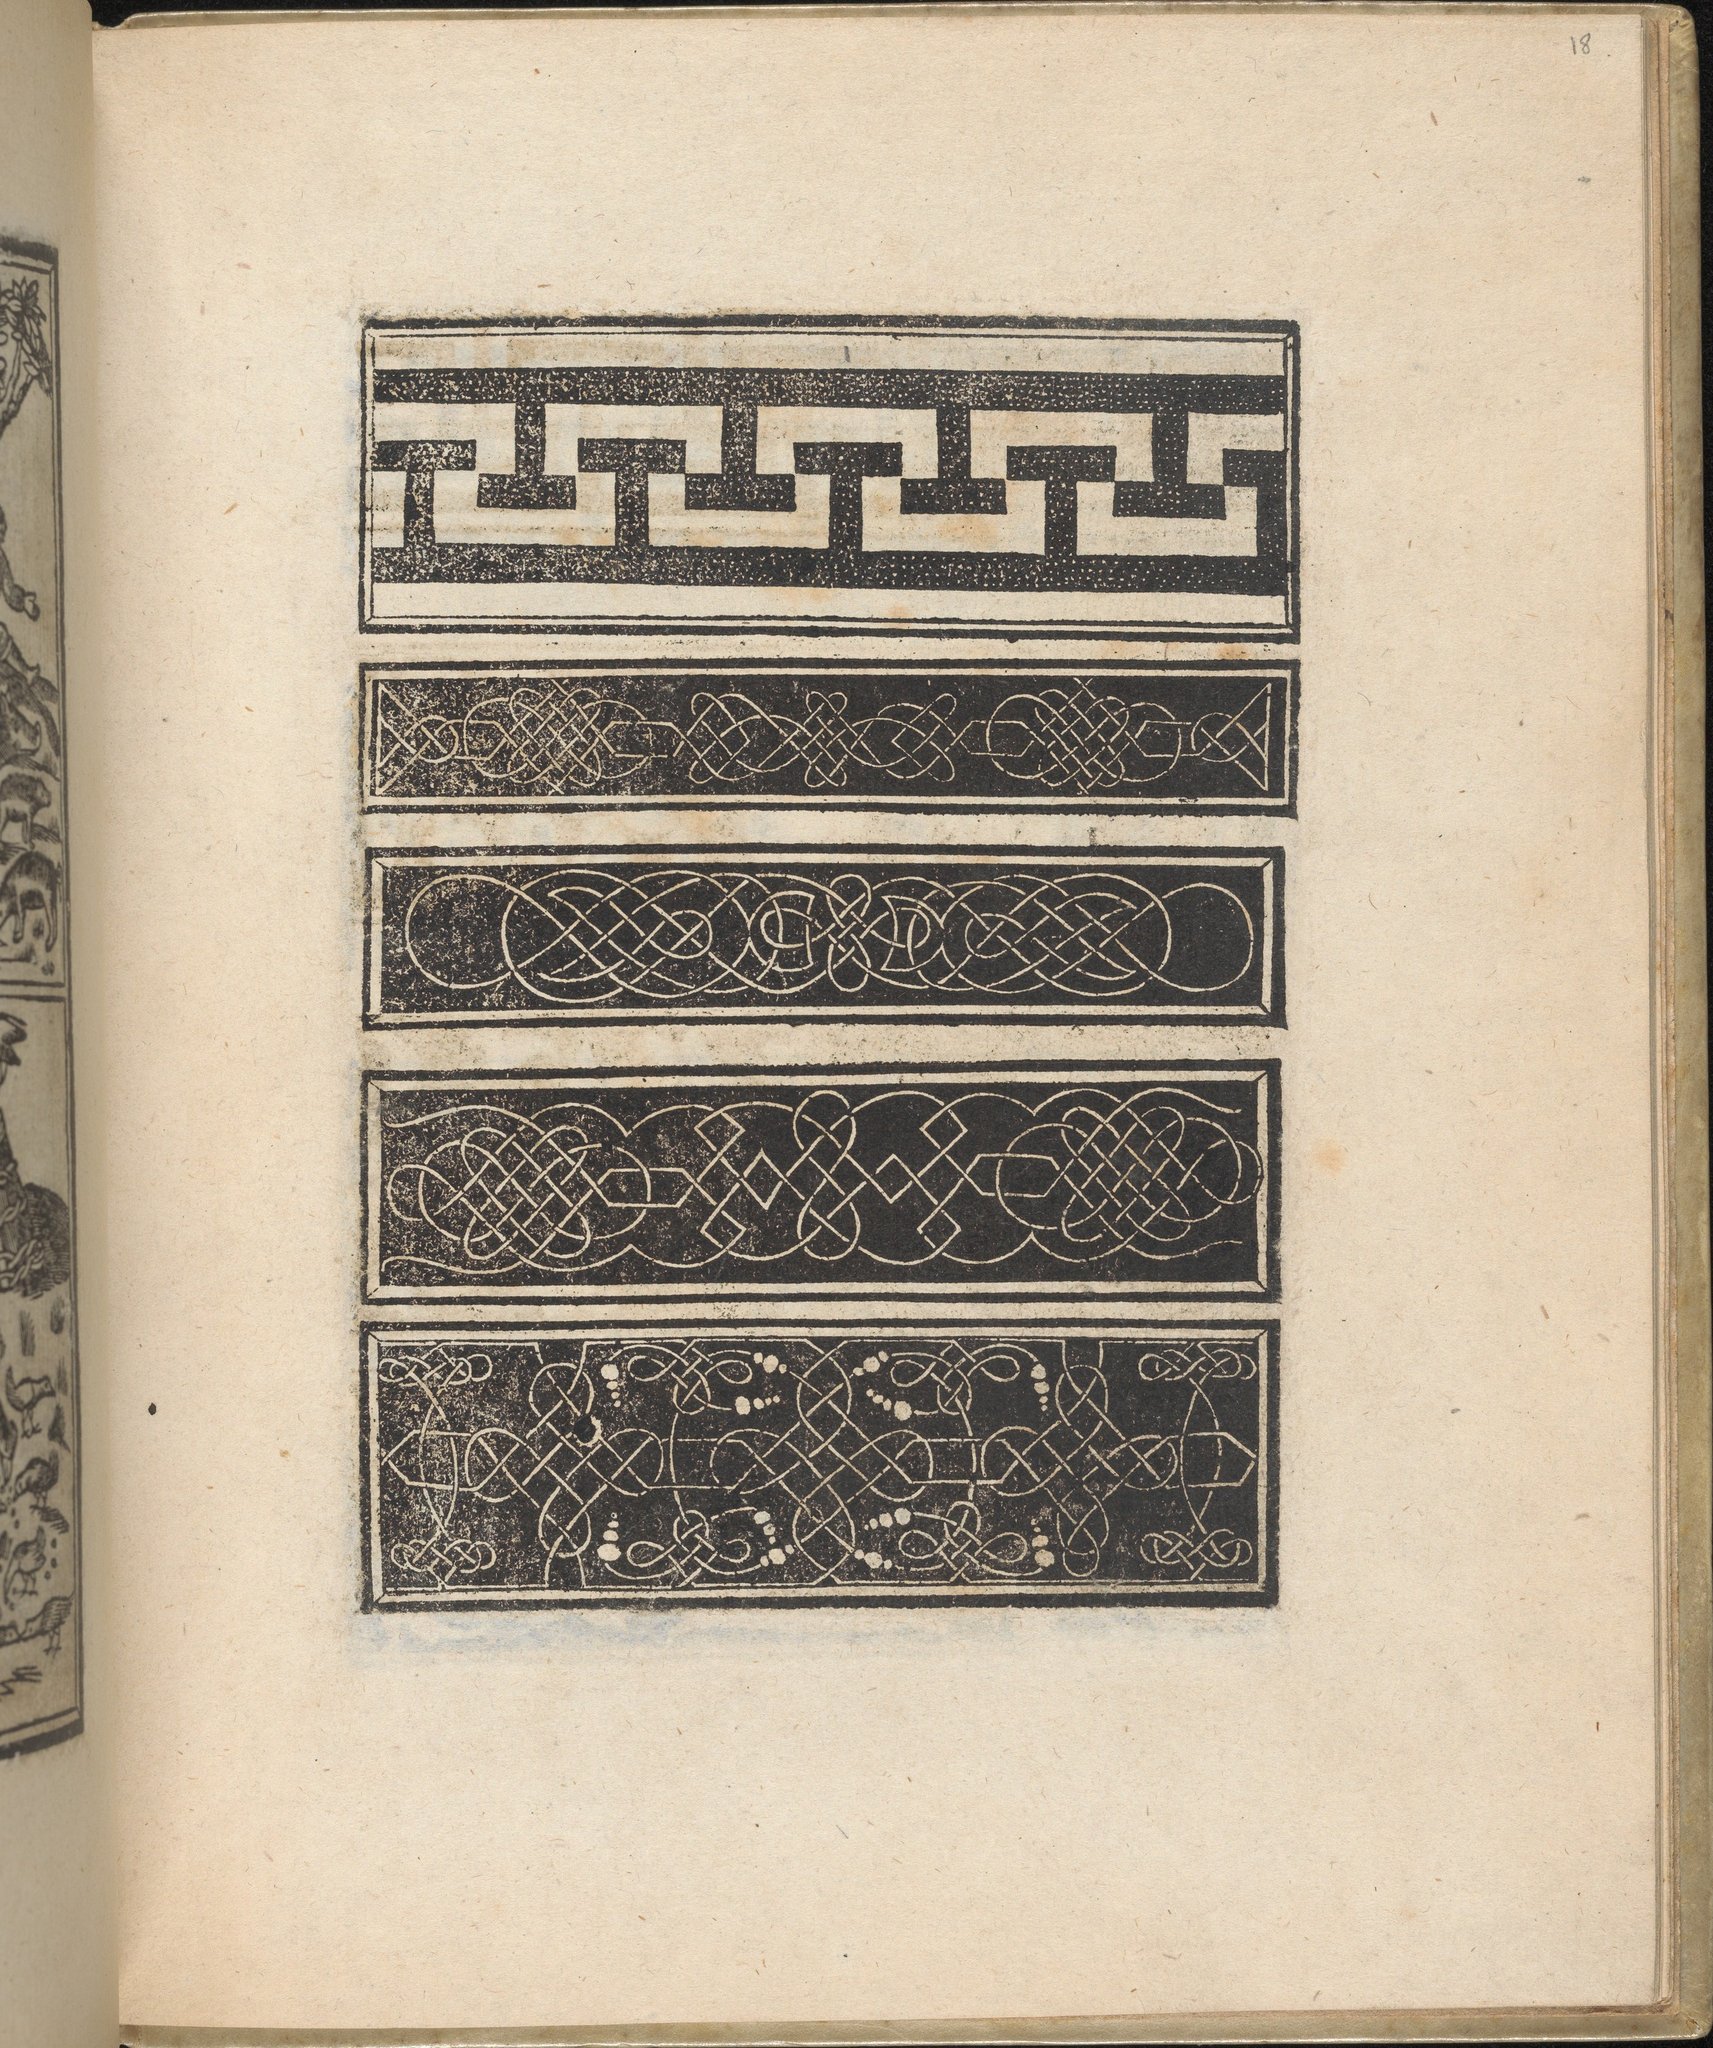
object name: book print ornament architecture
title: Trionfo Di Virtu. Libro Novo..., page 18 (verso)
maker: matteo pagano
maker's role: publisher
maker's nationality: italian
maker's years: 1515-1588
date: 1563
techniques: woodcut